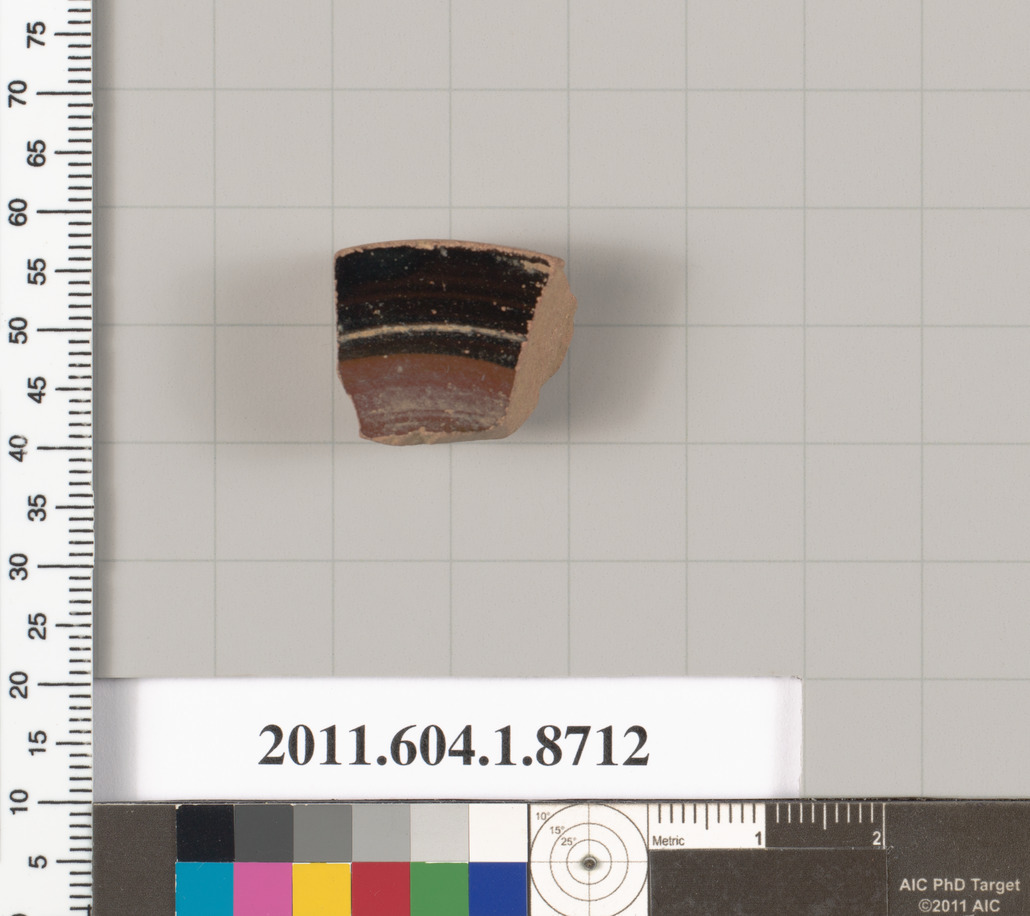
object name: kylix fragment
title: Terracotta fragment of a kylix (drinking cup)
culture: greek, attic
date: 600-401 BCE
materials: terracotta